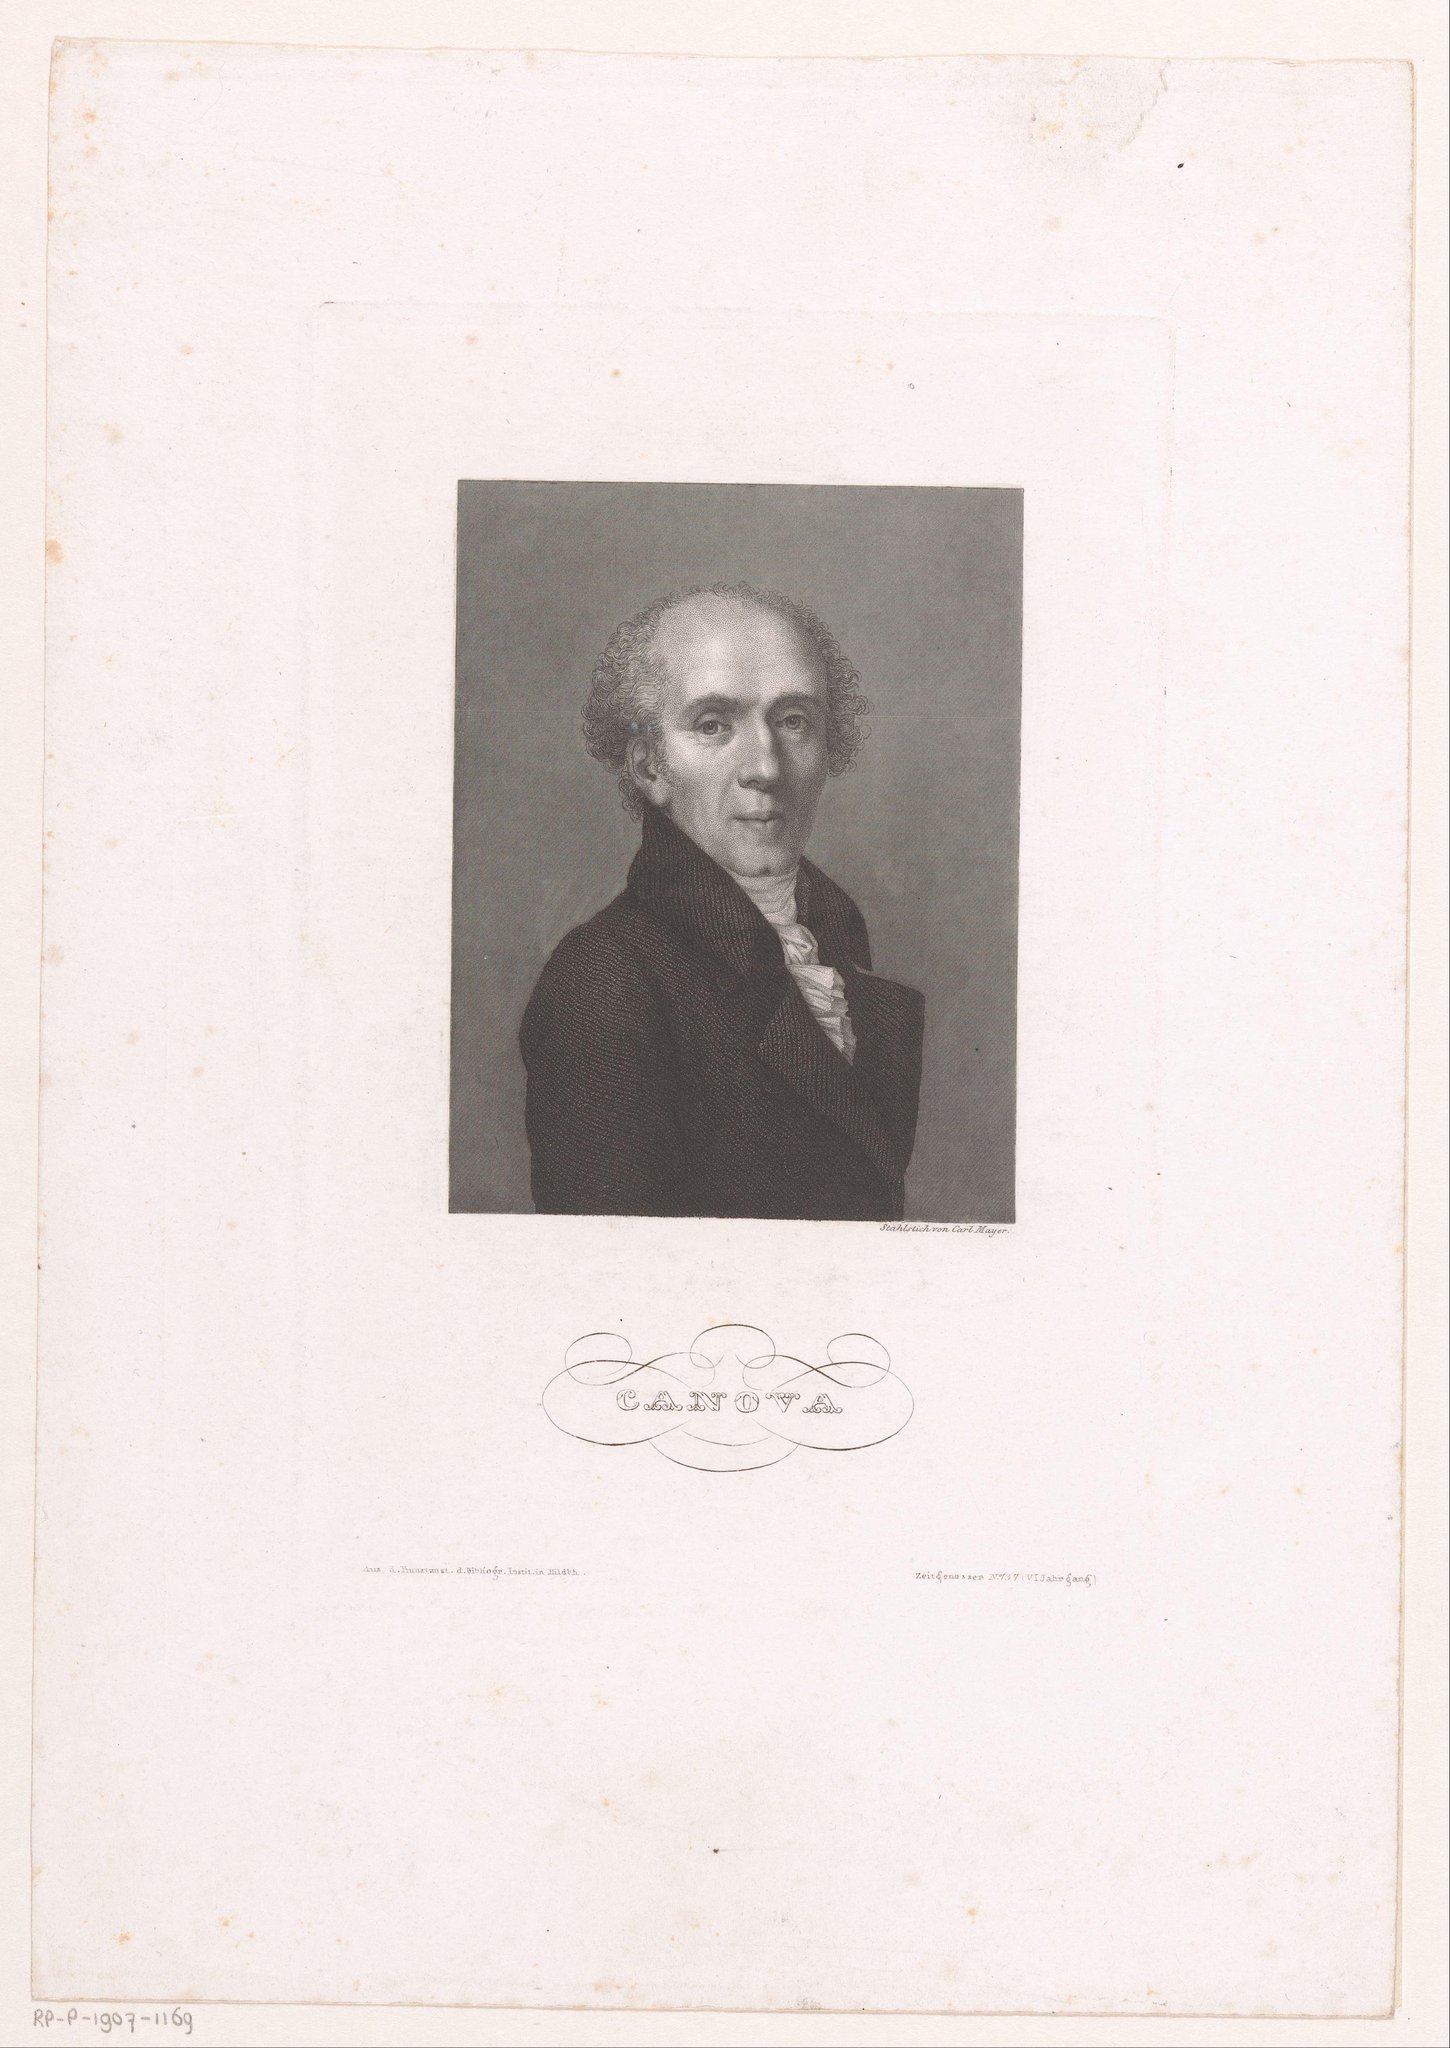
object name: print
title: Tijdgenoten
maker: carl mayer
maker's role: print maker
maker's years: 1798-1868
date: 1829-1840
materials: paper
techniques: engraving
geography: nuremberg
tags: venice, painter, draughtsman, sculptor, antonio canova, historical persons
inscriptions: collector's mark: Lugt 2228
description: Afkomstig uit de portretserie 'Zeitgenossen', uitgegeven tussen 1829 en circa 1840.